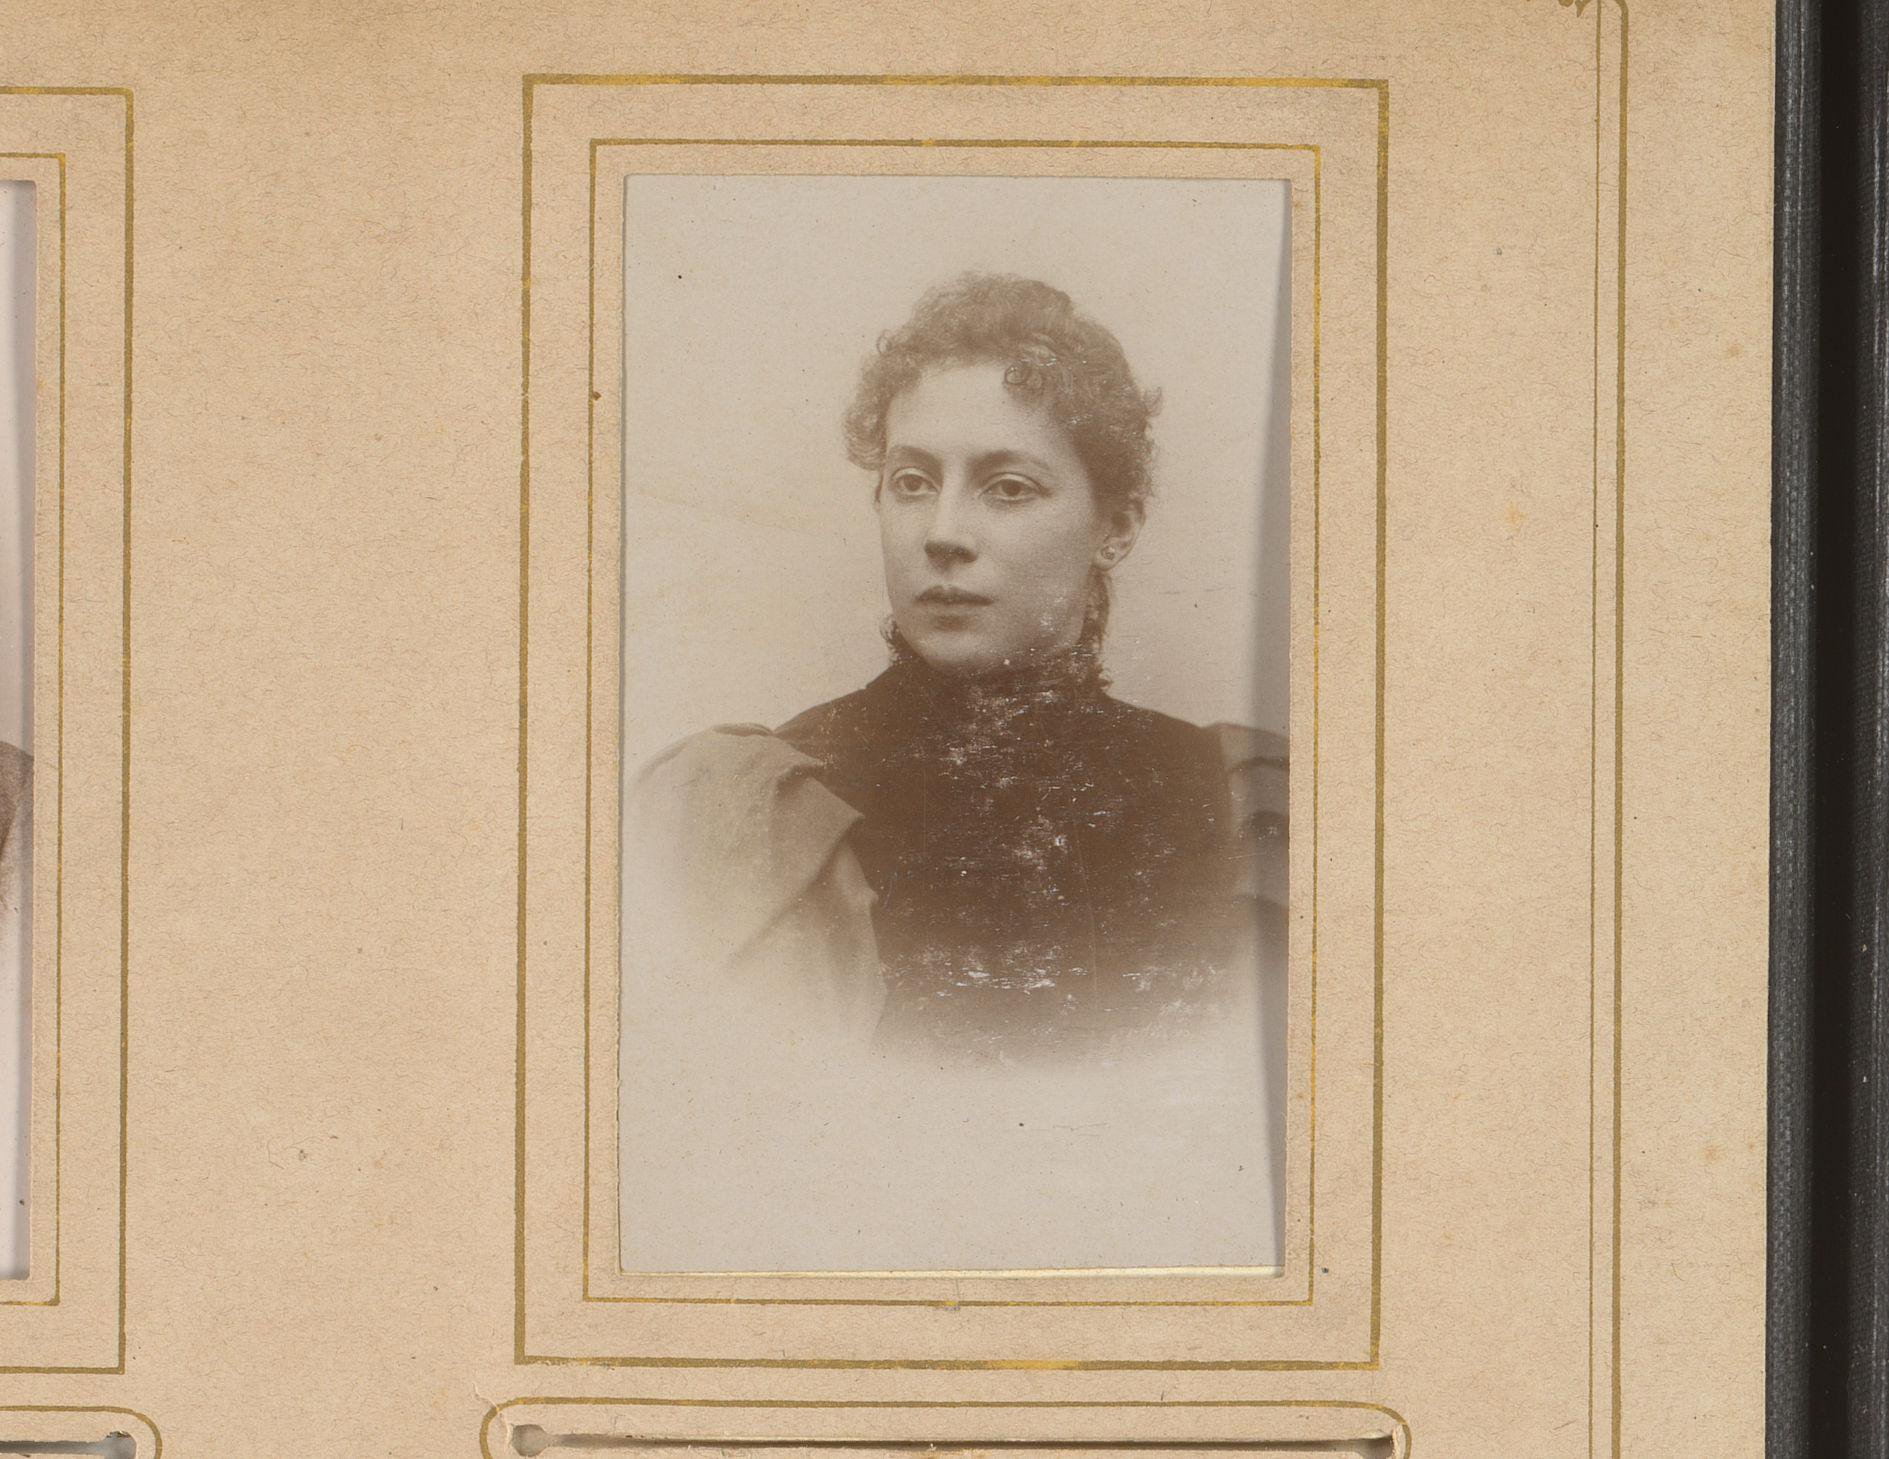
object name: photograph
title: Portret van een vrouw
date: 1894-1895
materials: cardboard, photographic support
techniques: collodion silver print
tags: adult woman, historical persons